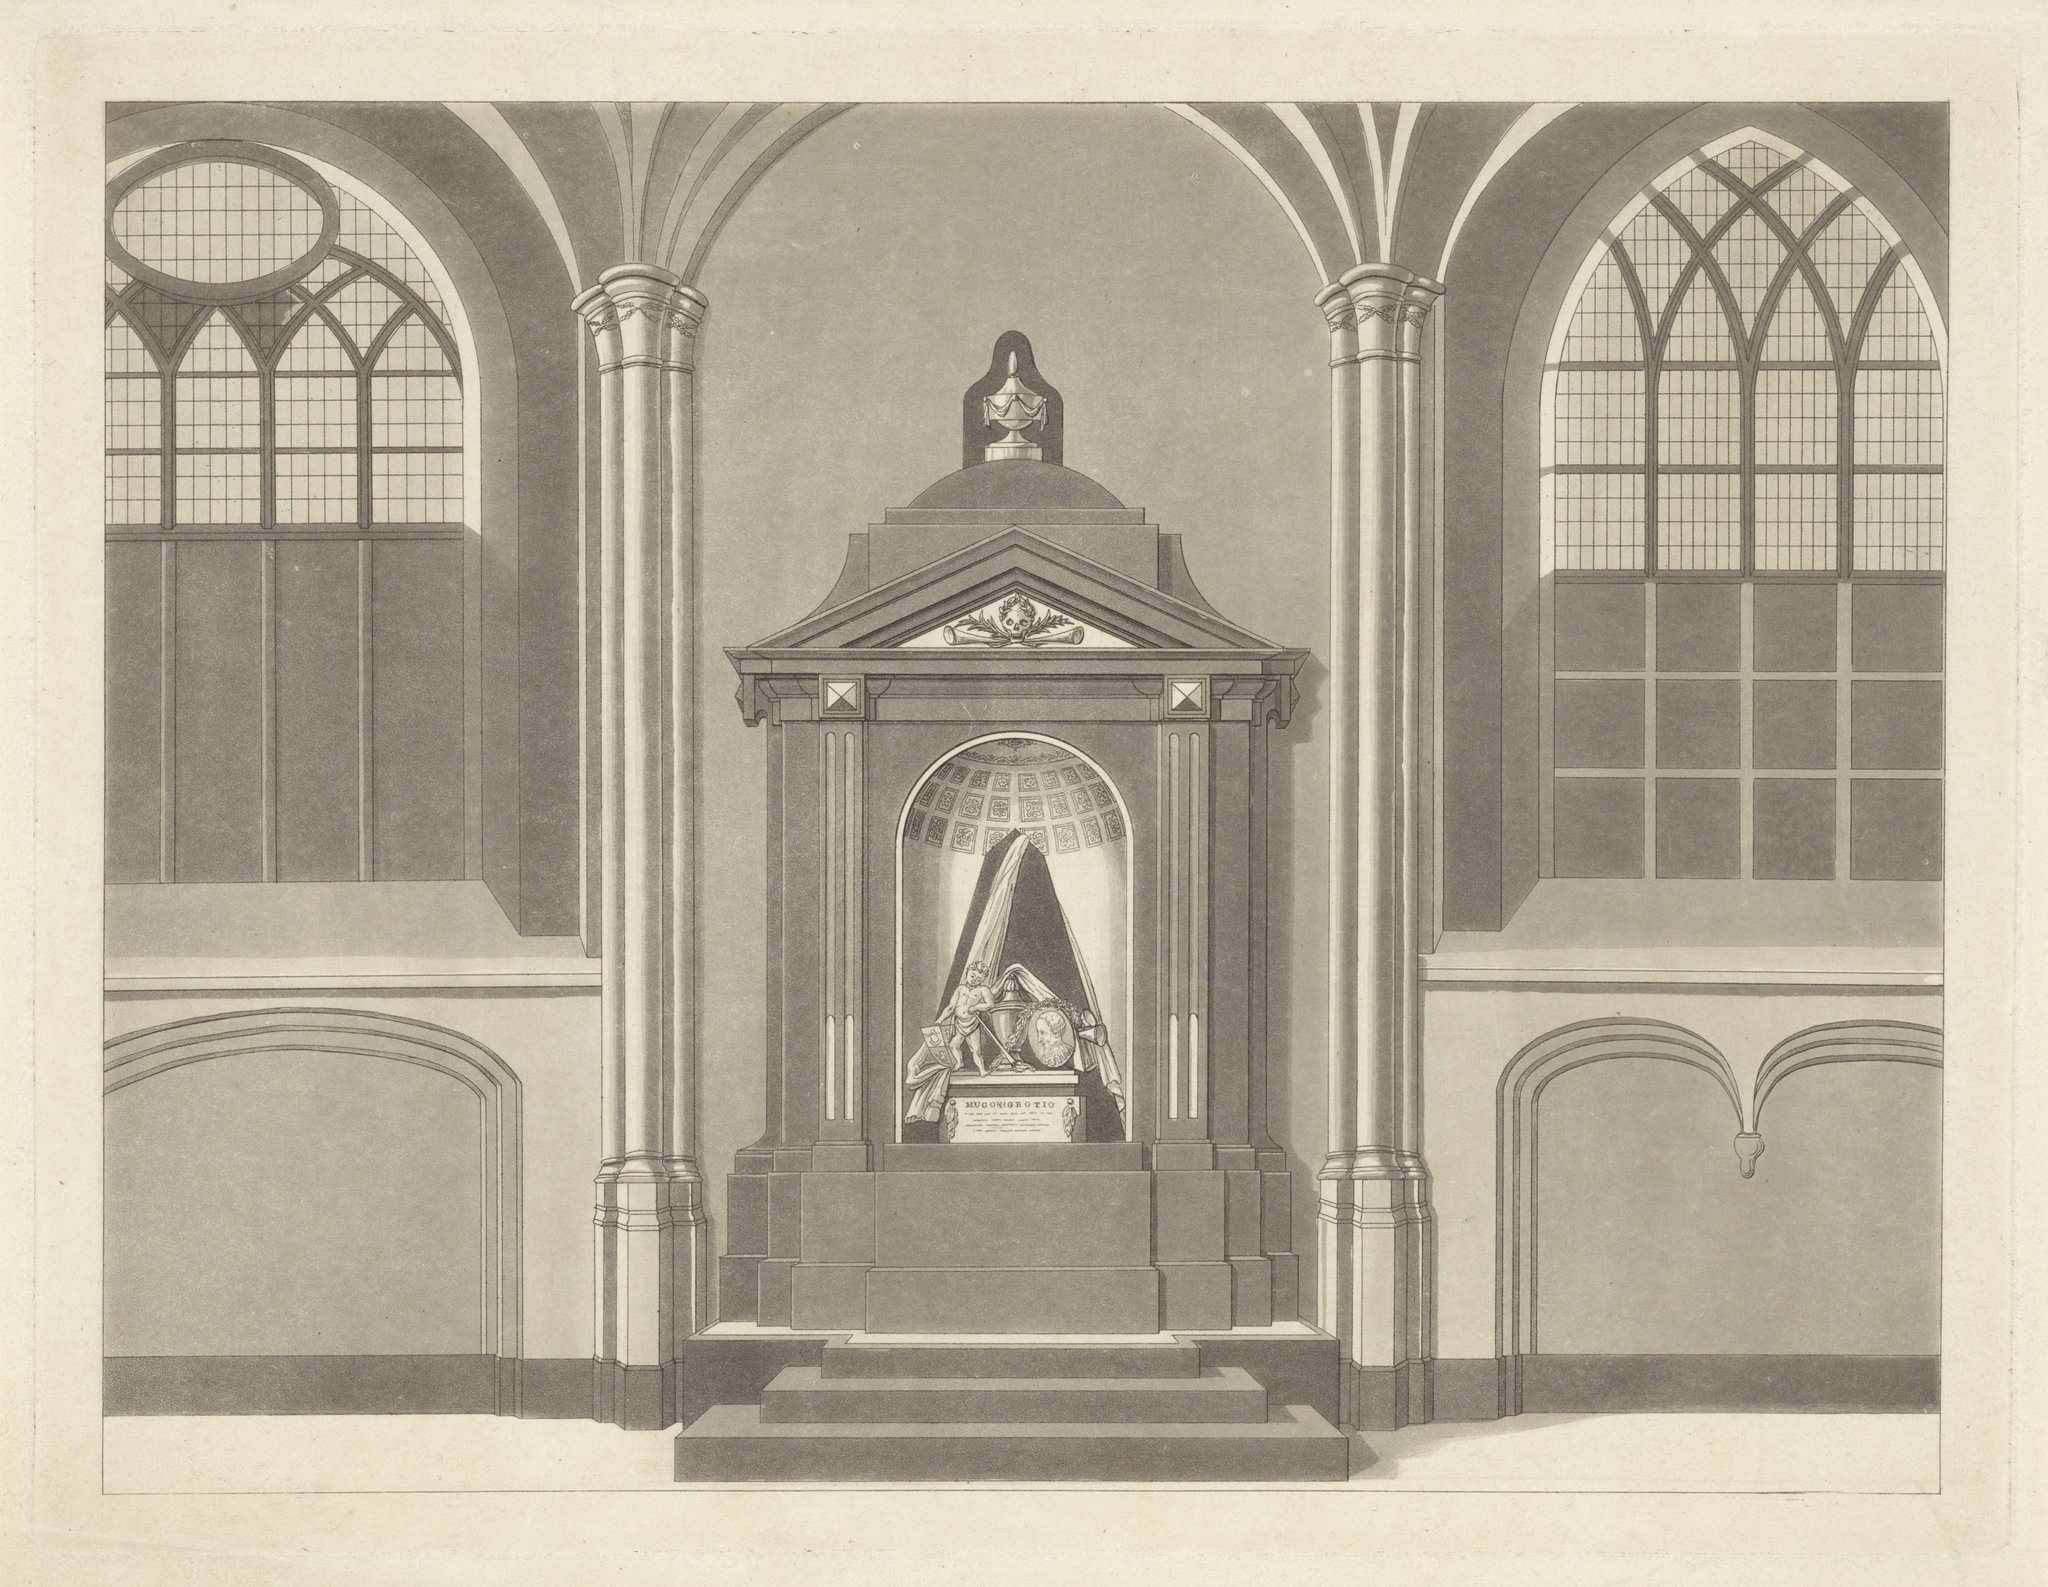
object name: print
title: Gedenkteken voor Hugo de Groot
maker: johannes cornelis zürcher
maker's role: print maker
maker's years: 1794-1882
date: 1804-1882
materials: paper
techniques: aquatint, etching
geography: amsterdam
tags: delft, hugo de groot, other memorial structures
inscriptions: collector's mark: Lugt 2228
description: Gedenkteken voor Hugo de Groot in de Nieuwe Kerk te Delft.